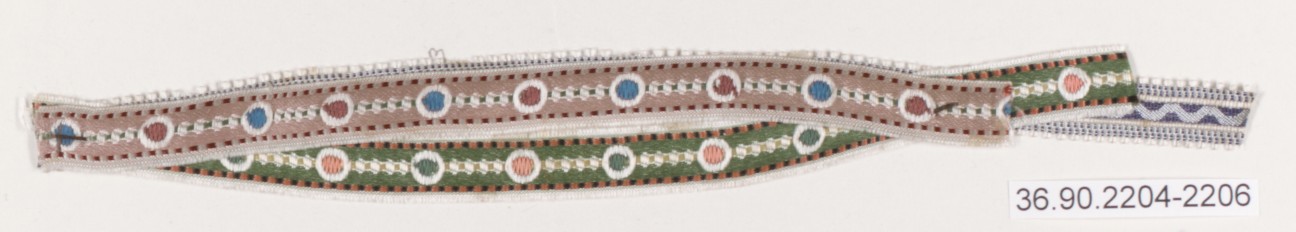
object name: piece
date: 1801-1900